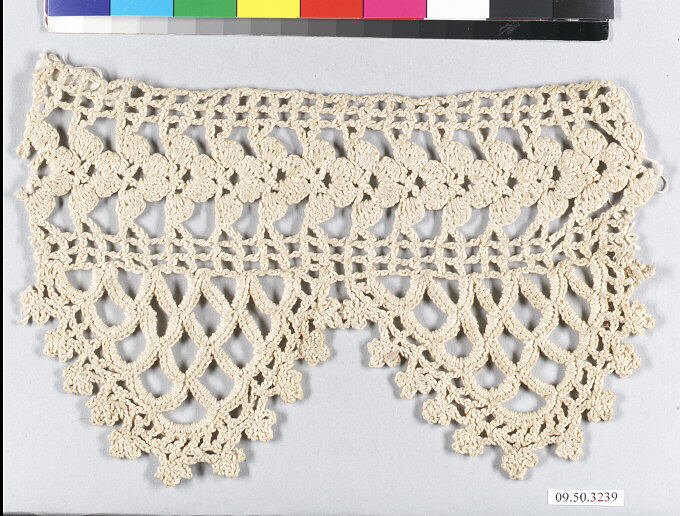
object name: sample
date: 1801-1900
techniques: crochet